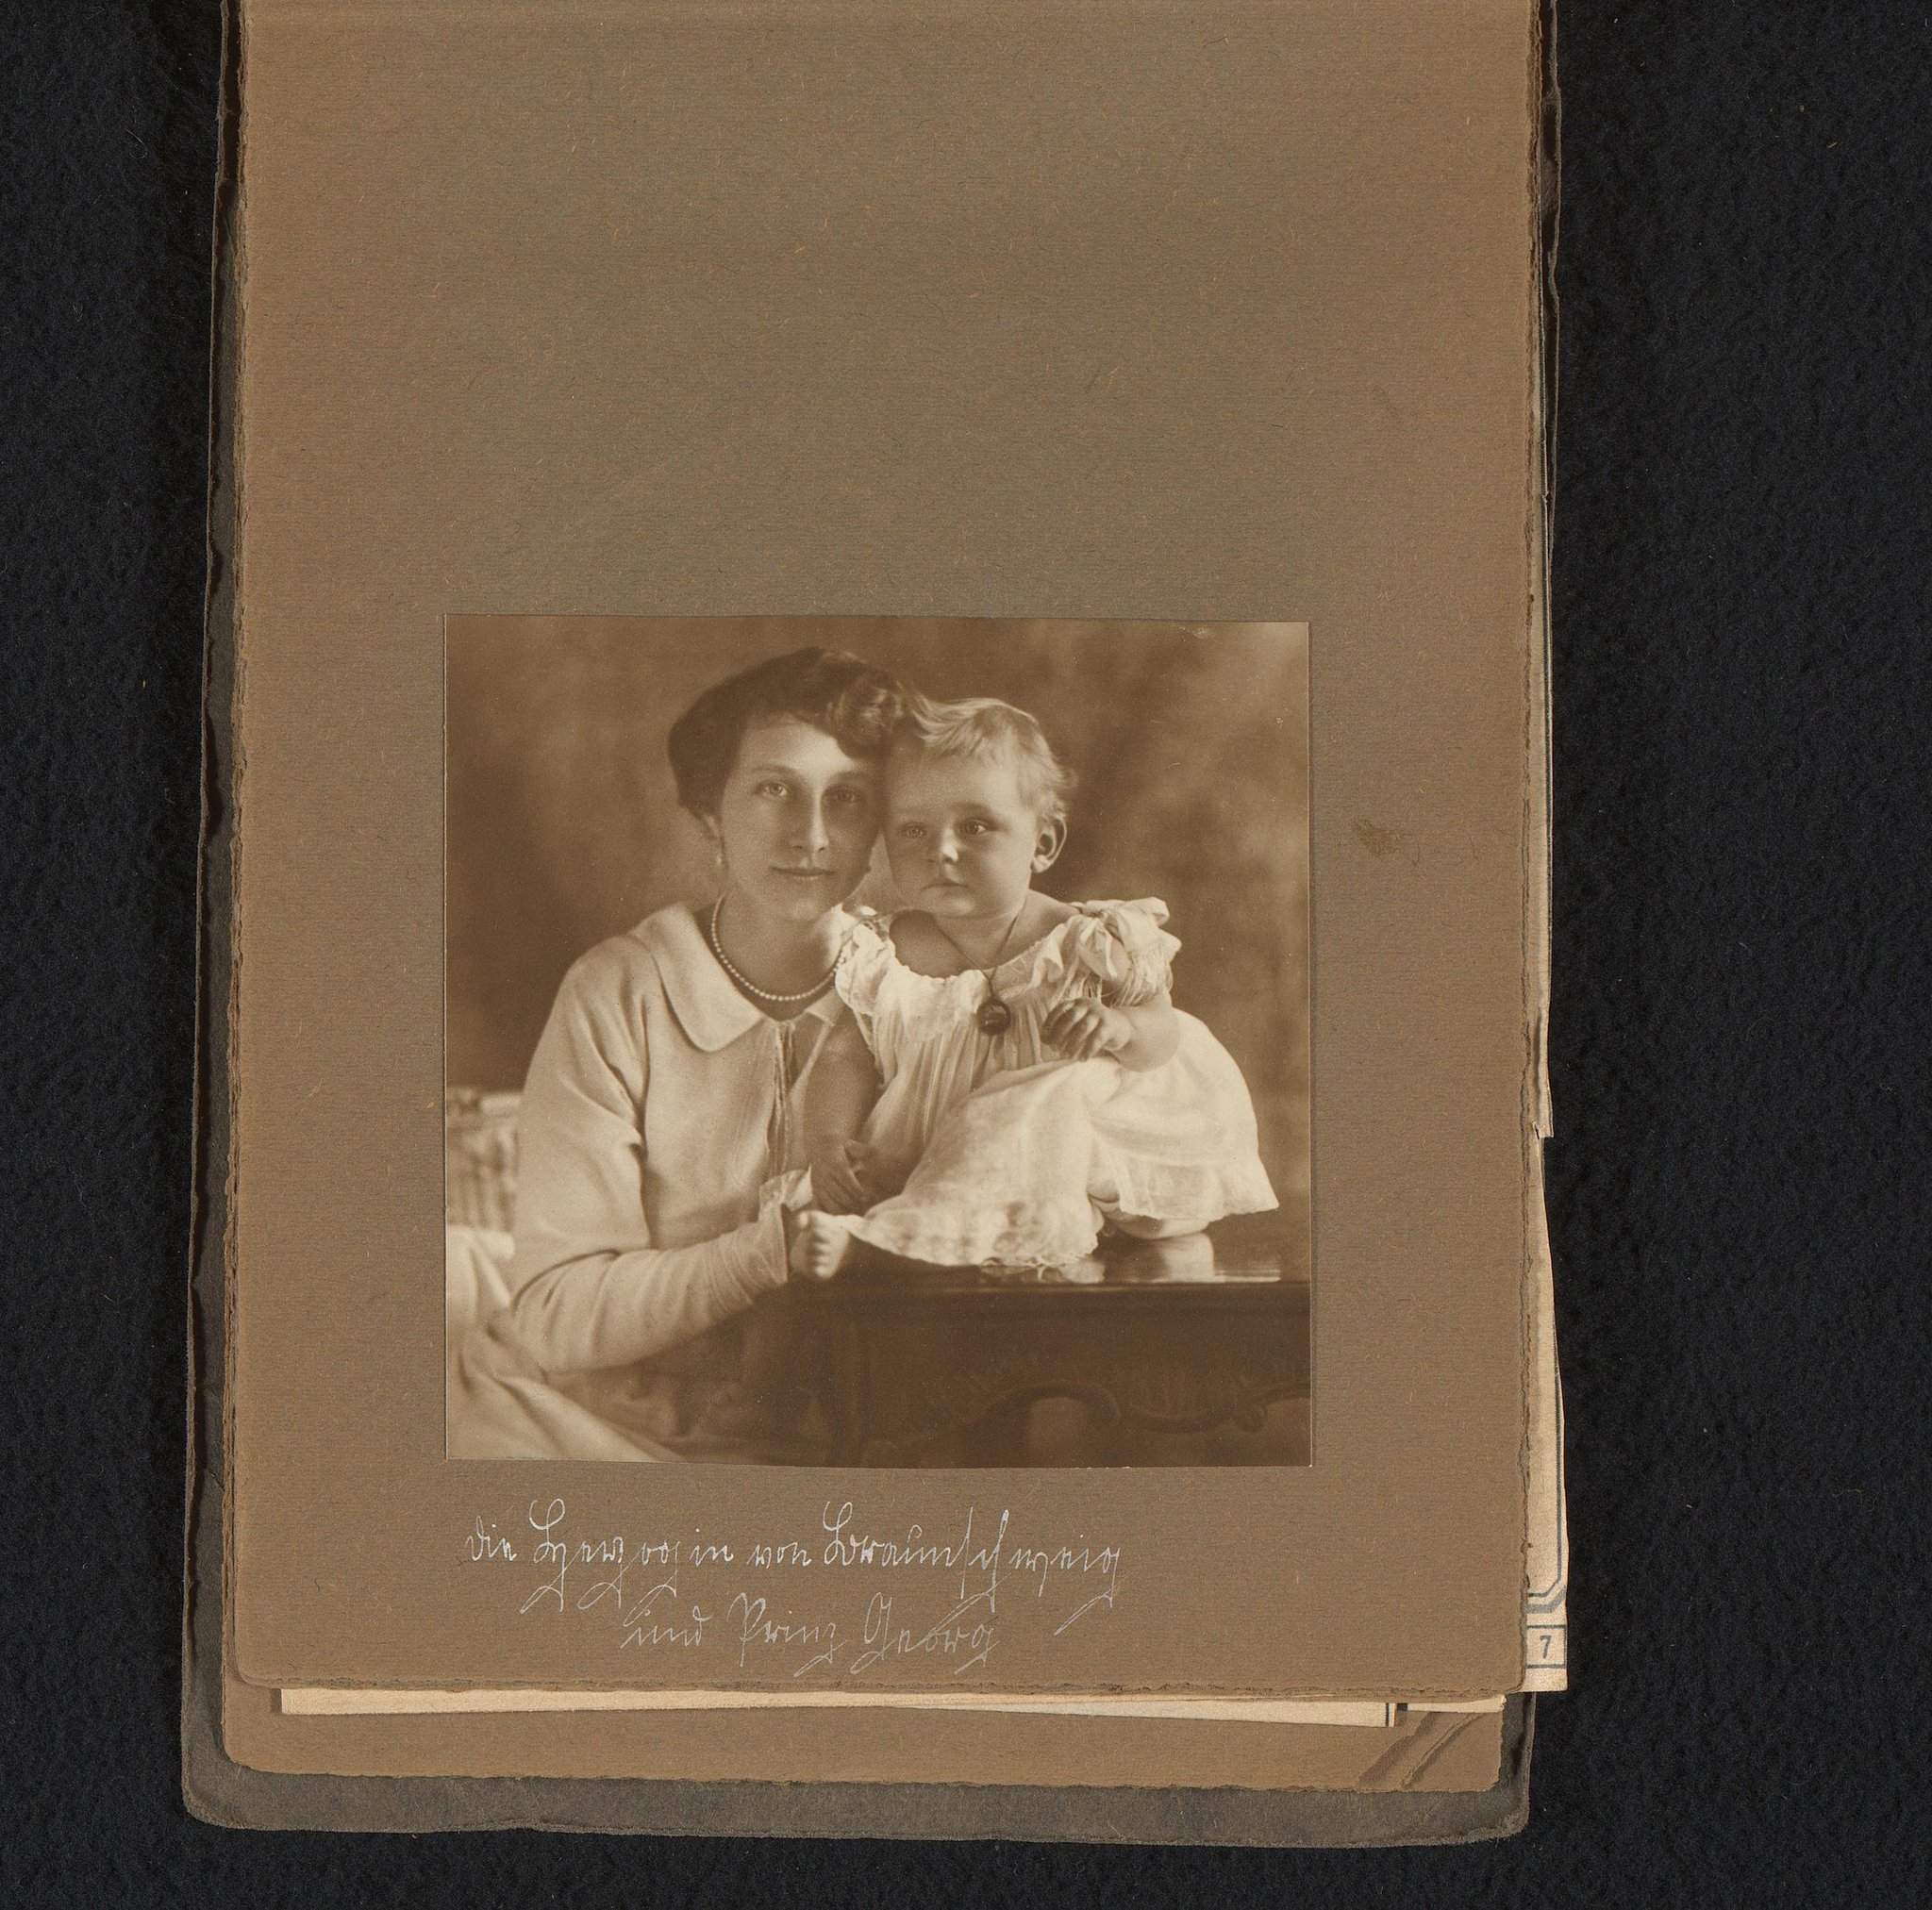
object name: photograph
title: Portret van Victoria Louise van Pruisen met haar zoon George Willem van Brunswijk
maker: Anonymous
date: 1915-1916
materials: paper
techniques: gelatin silver print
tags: prince, historical persons, princess